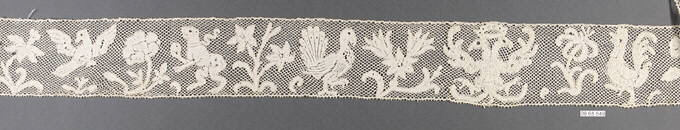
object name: piece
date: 1701-1800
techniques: lace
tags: animals,birds,flowers,leaves